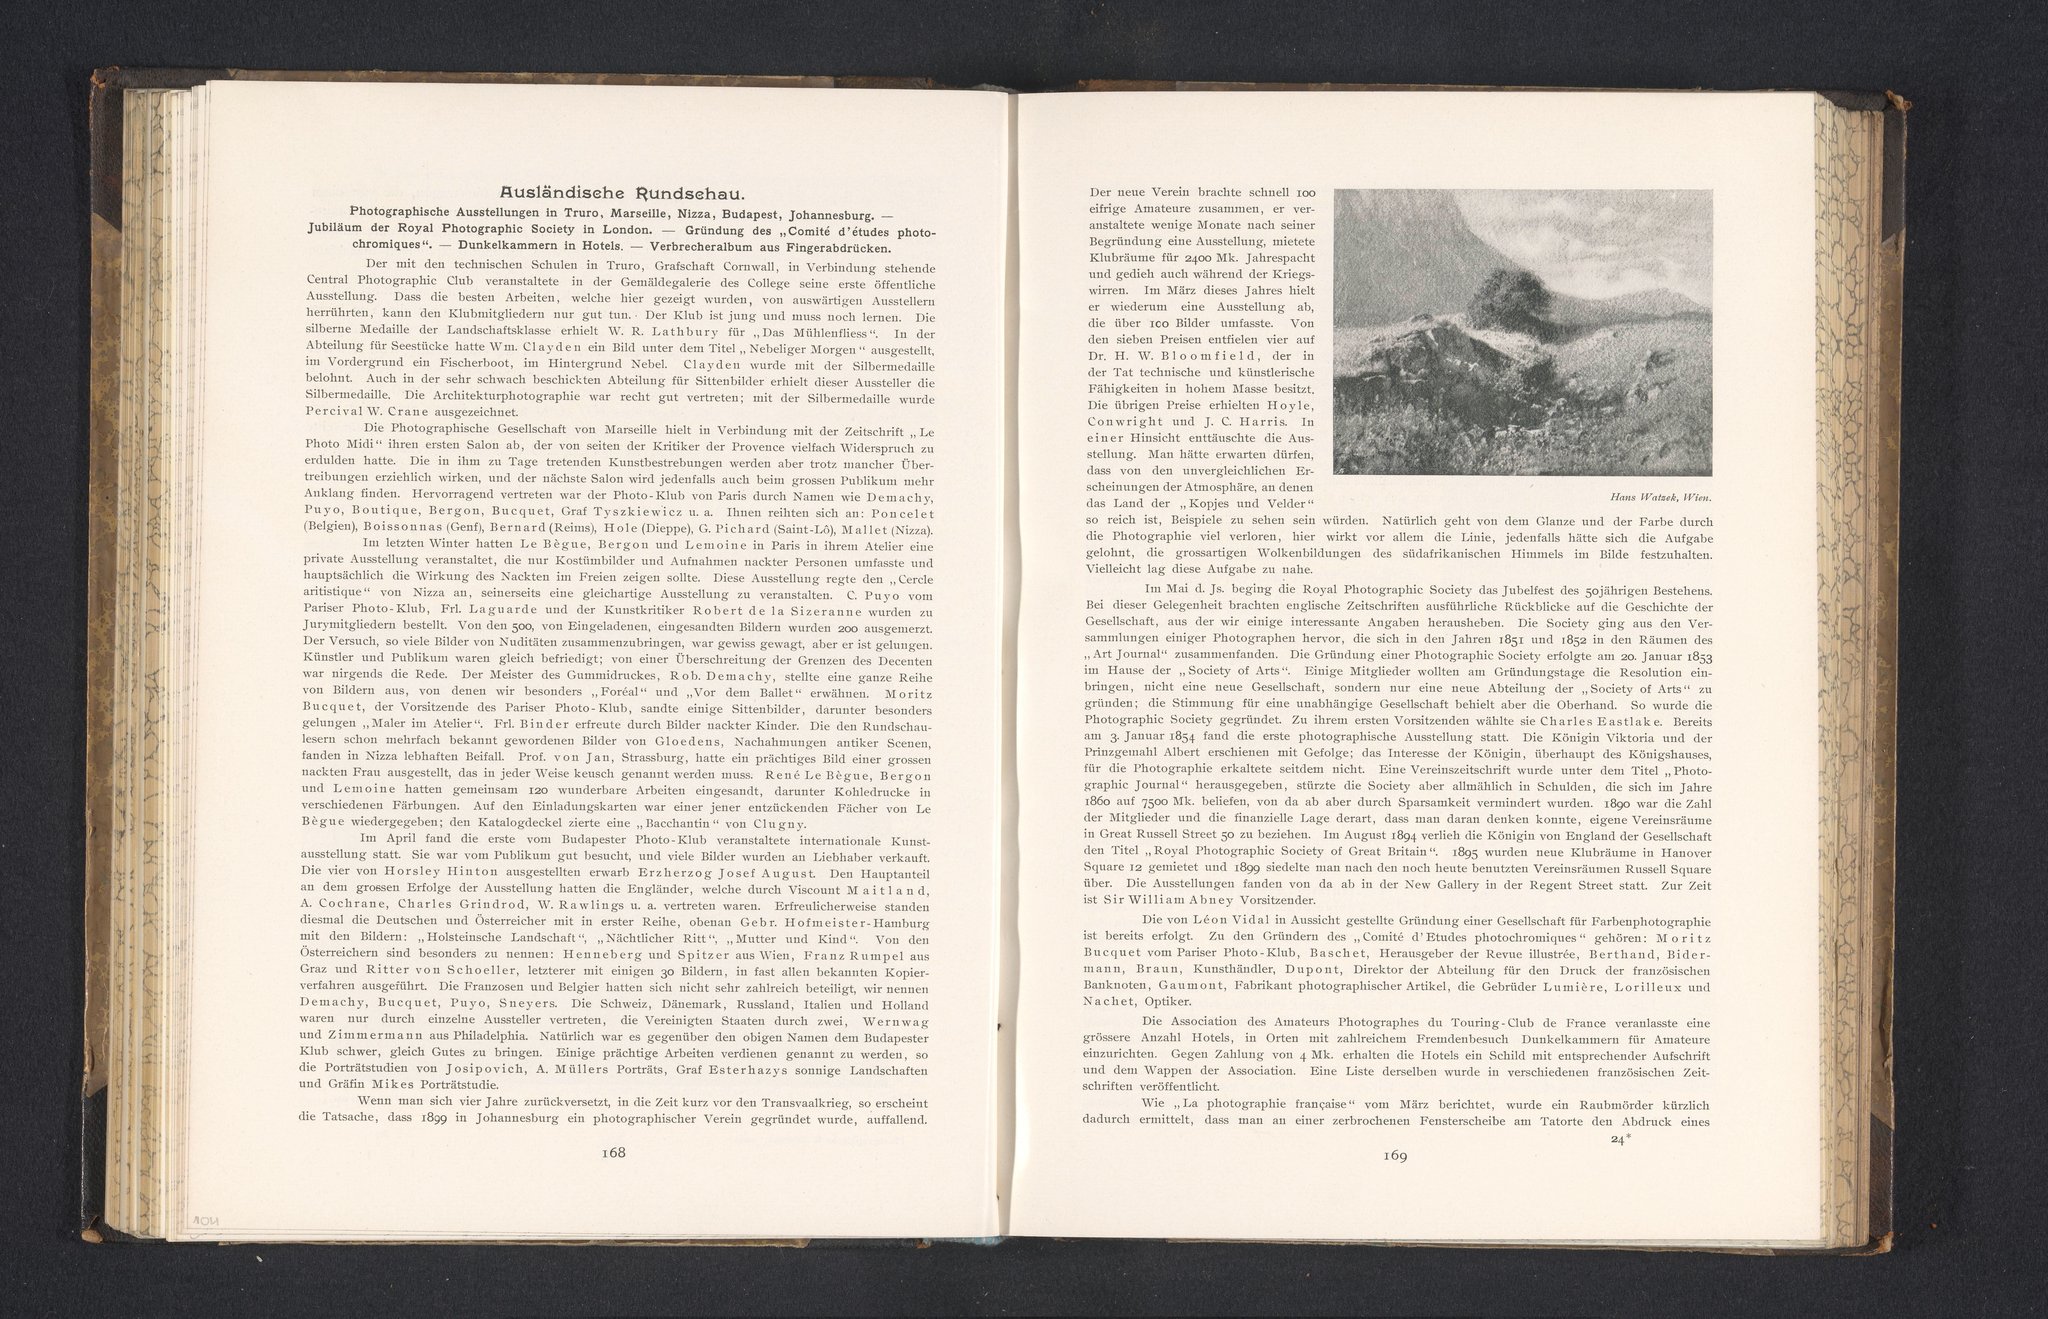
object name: page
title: Landschap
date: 1898-1903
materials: paper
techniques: autotype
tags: landscapes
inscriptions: monogram: ‘AG’